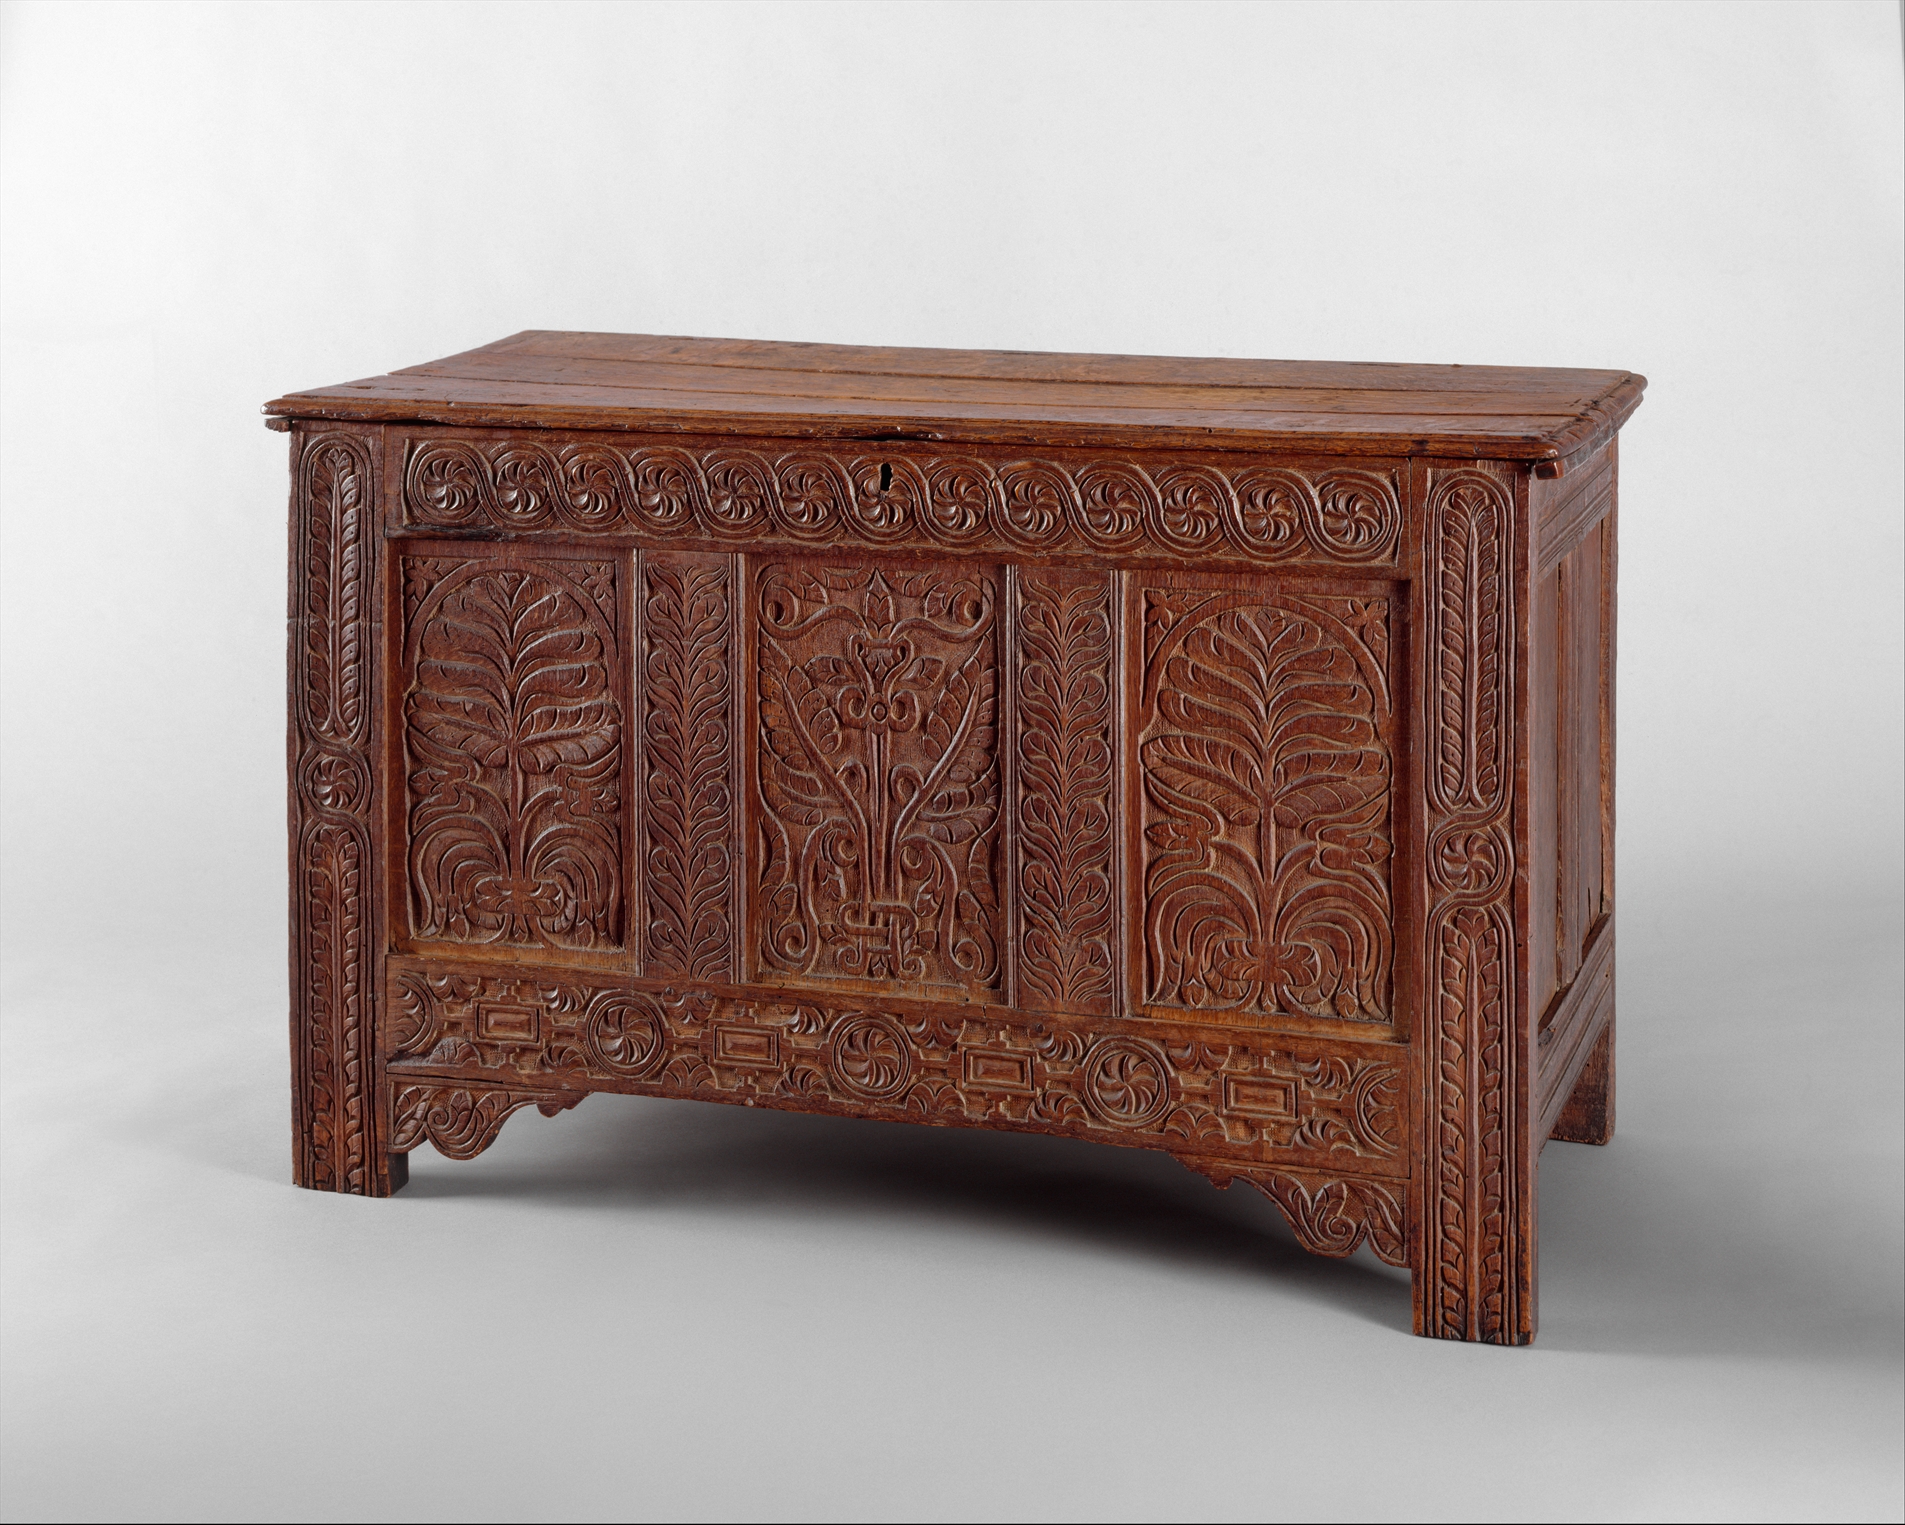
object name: chest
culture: american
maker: william searle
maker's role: maker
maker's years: 1611-1667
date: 1663-1680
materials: wood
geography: united states